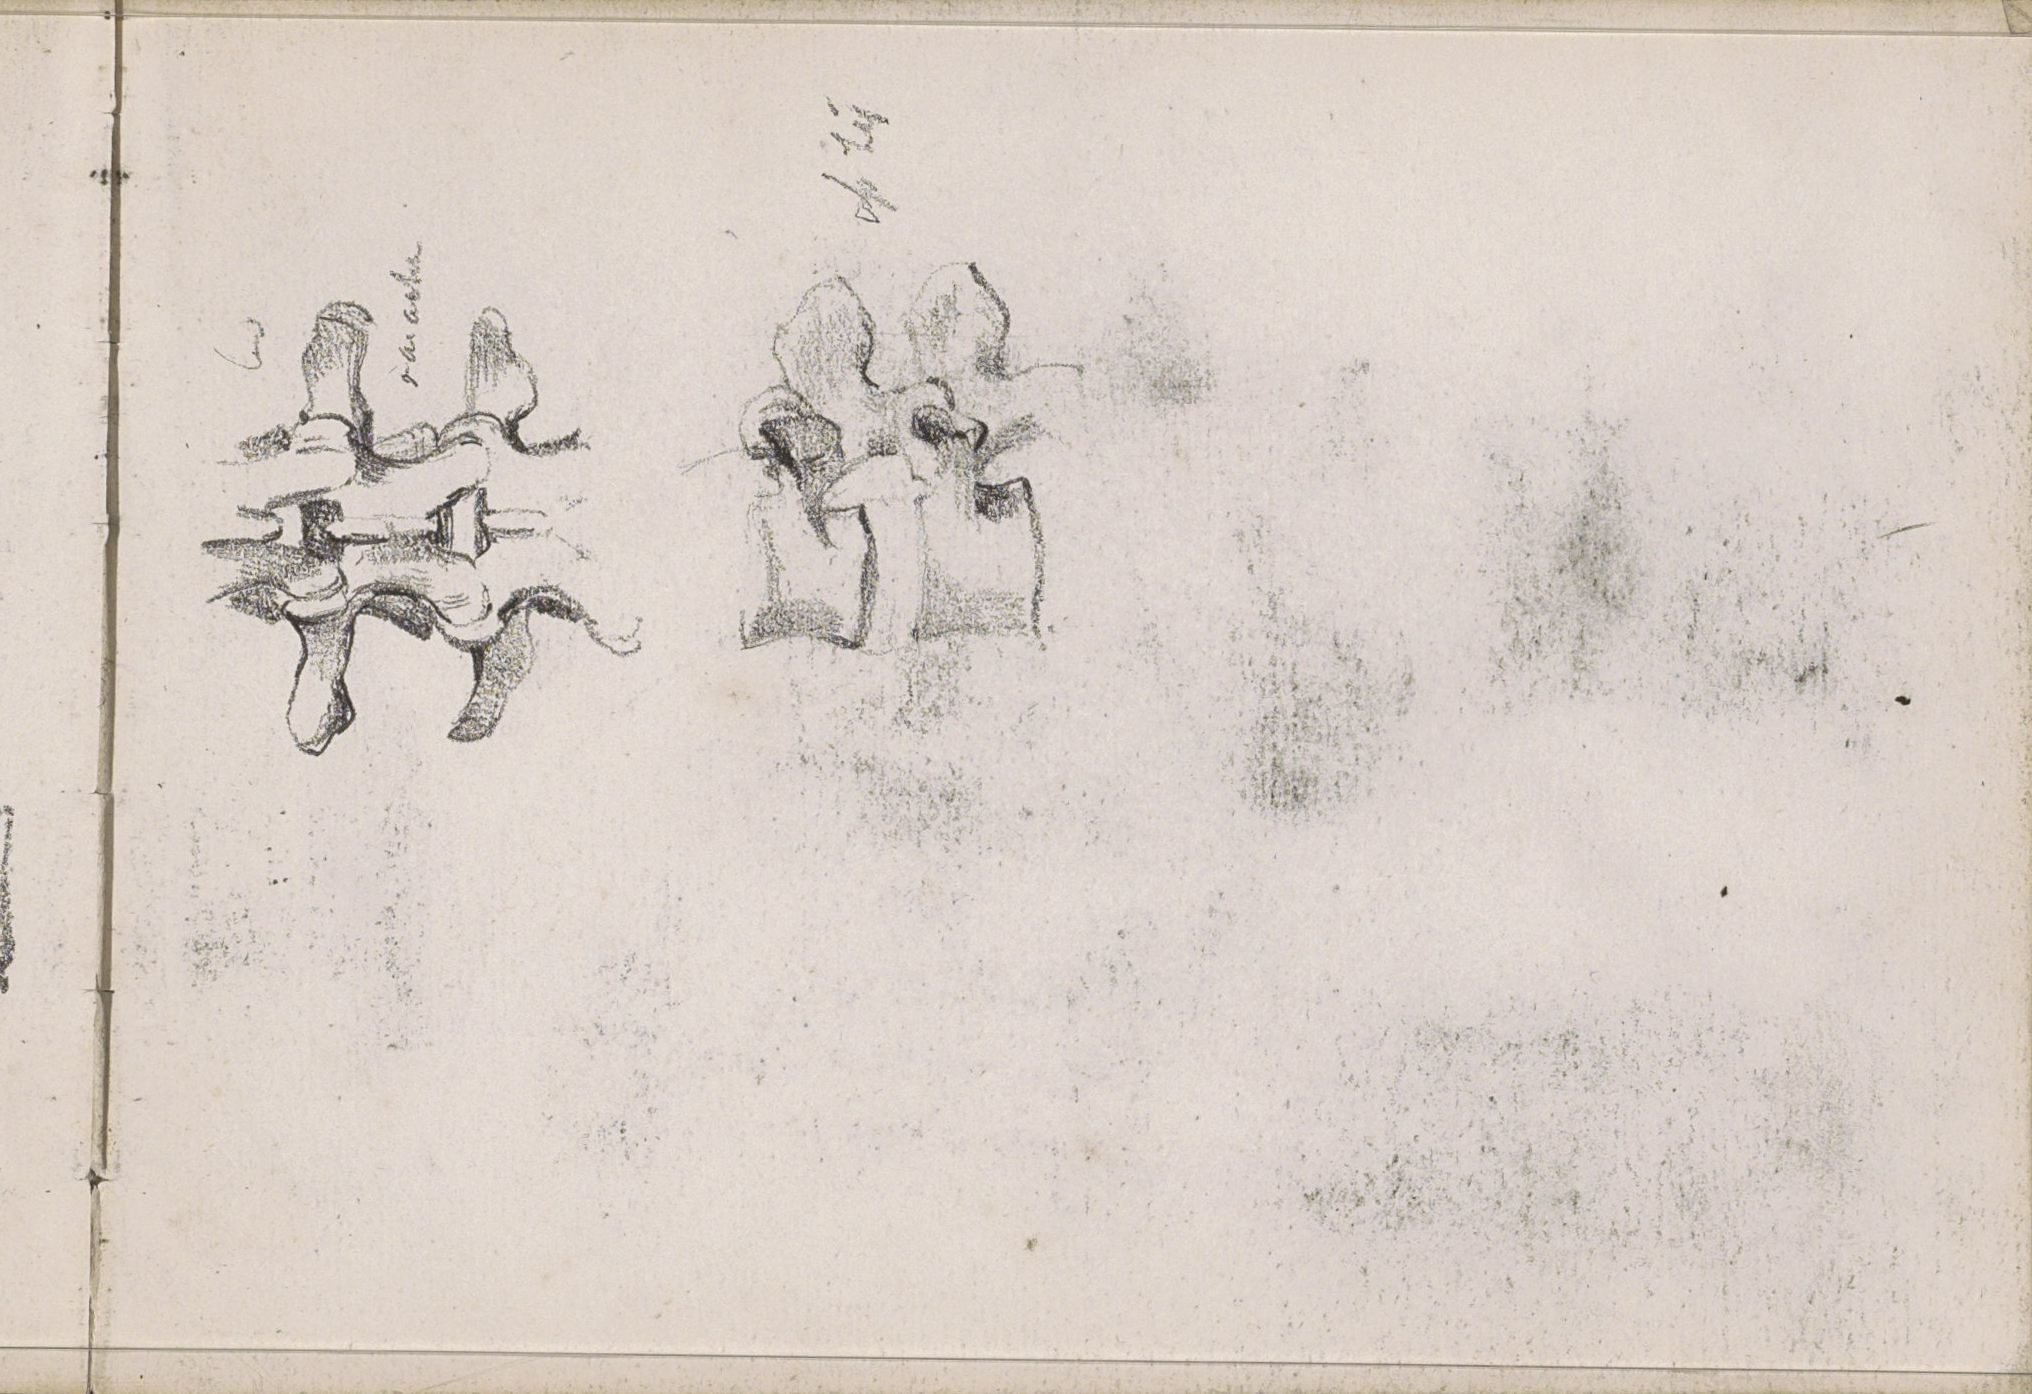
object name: sketchbook leaf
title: Menselijke wervels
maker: jac van looij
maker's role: draughtsman, painter, print maker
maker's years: 1855-1930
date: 1877-1880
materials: paper, pencil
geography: amsterdam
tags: spine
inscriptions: annotation: ‘[...]/ van ach/ op zij’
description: Blad 19 recto uit een schetsboek met 27 bladen.